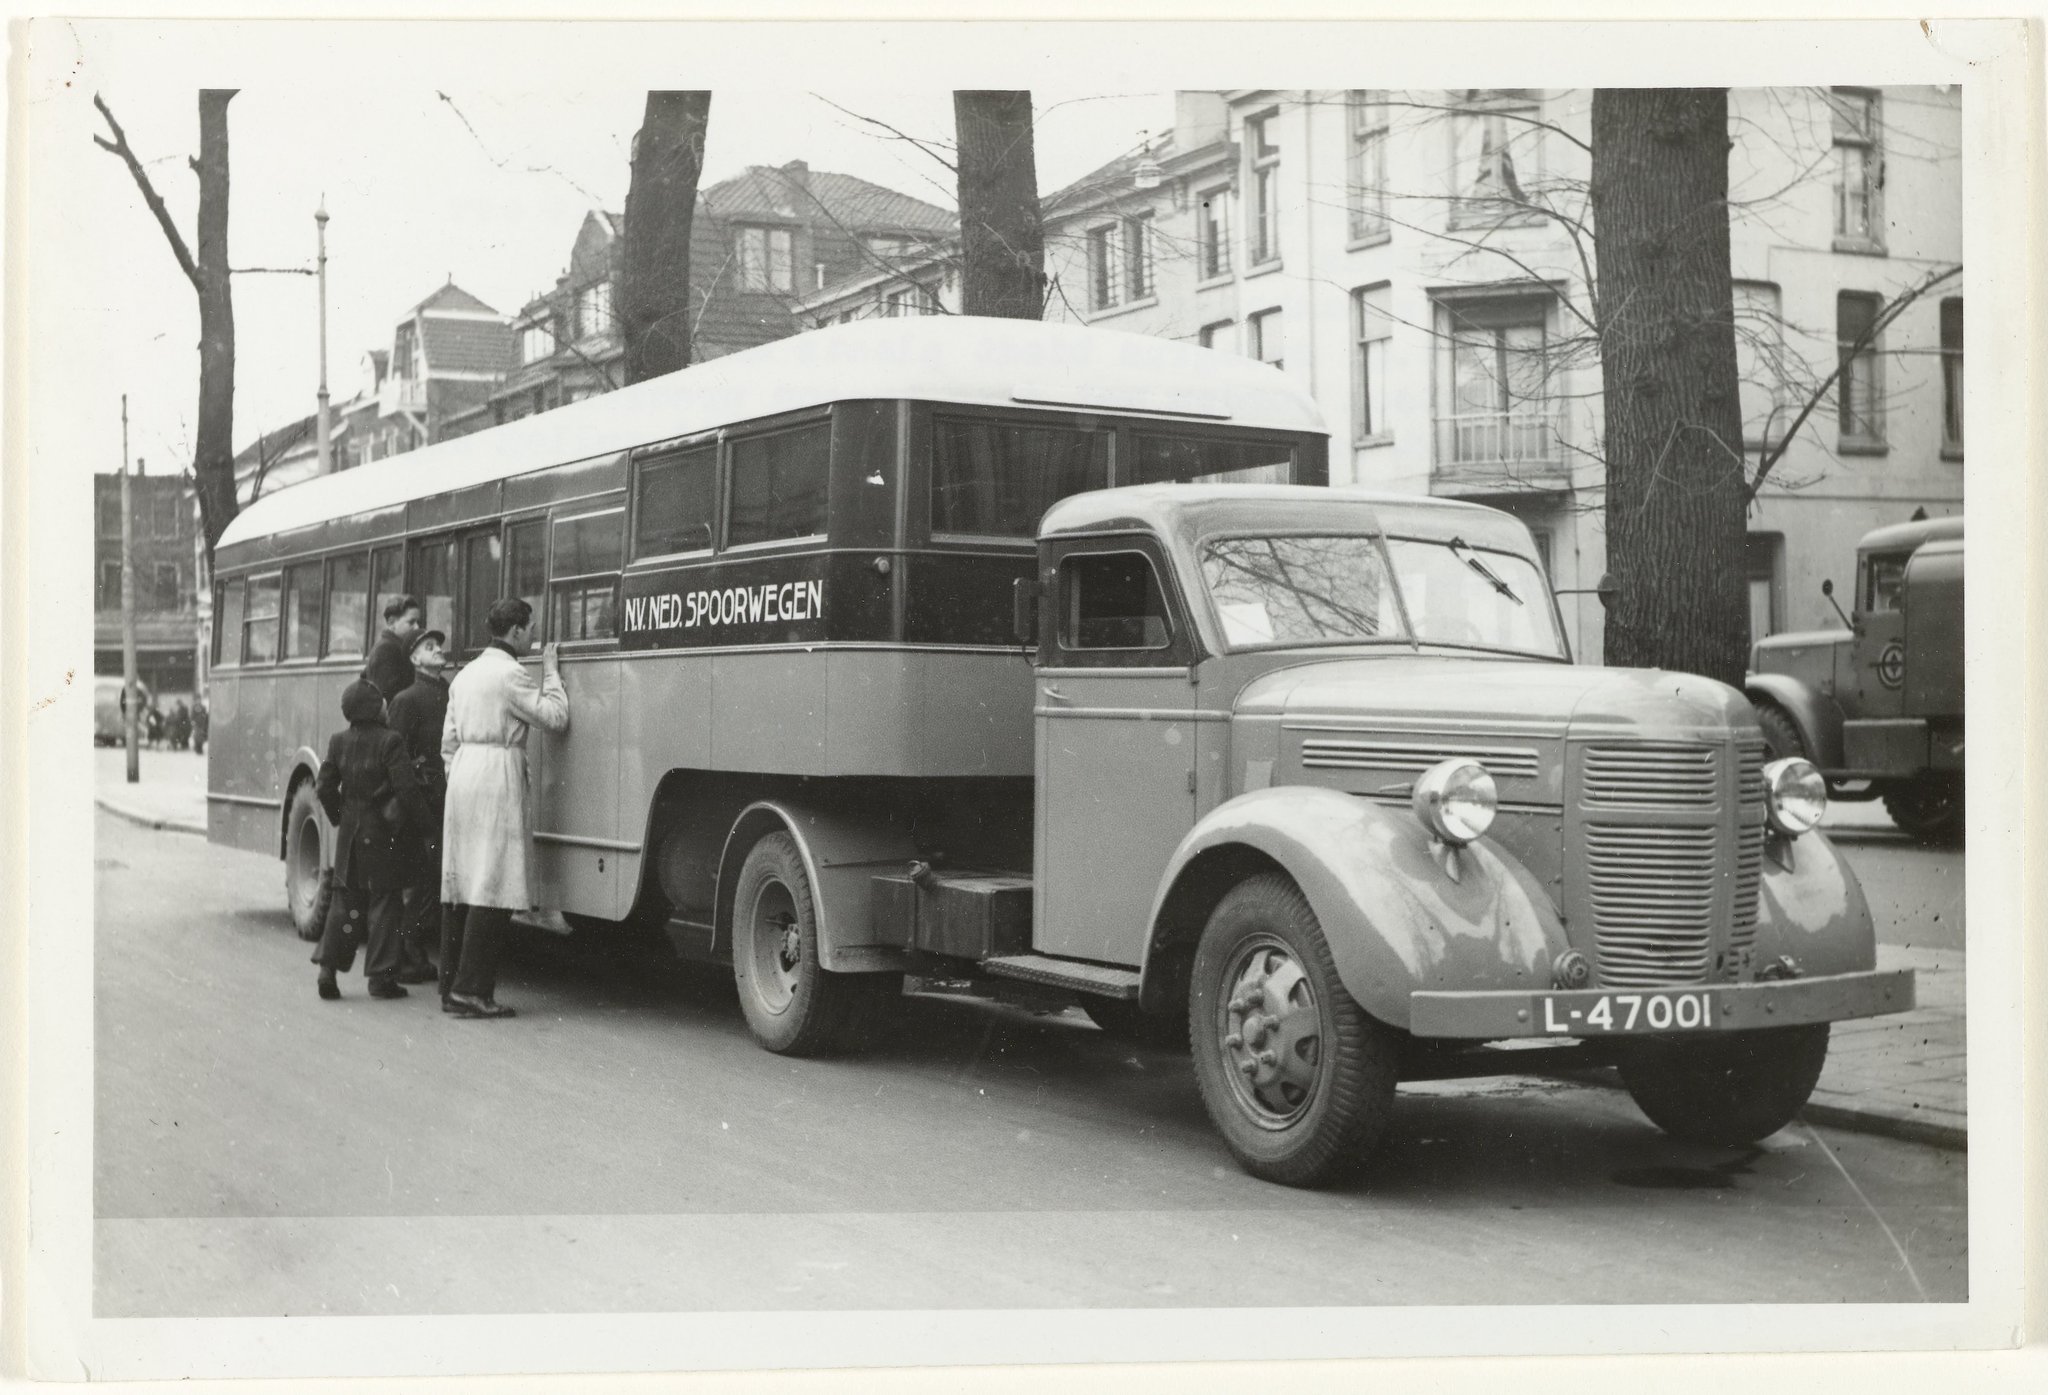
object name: photograph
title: Bus van de Nederlandse Spoorwegen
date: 1945-1946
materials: photographic support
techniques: photography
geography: netherlands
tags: netherlands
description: Een bus van de Nederlandse Spoorwegen. Bussen, afkomstig van Van Doorn's aanhangwagenfabriek, moesten de overbelaste treinen ontlasten. Op de foto een proefrit. In een bus konden 87 passagiers